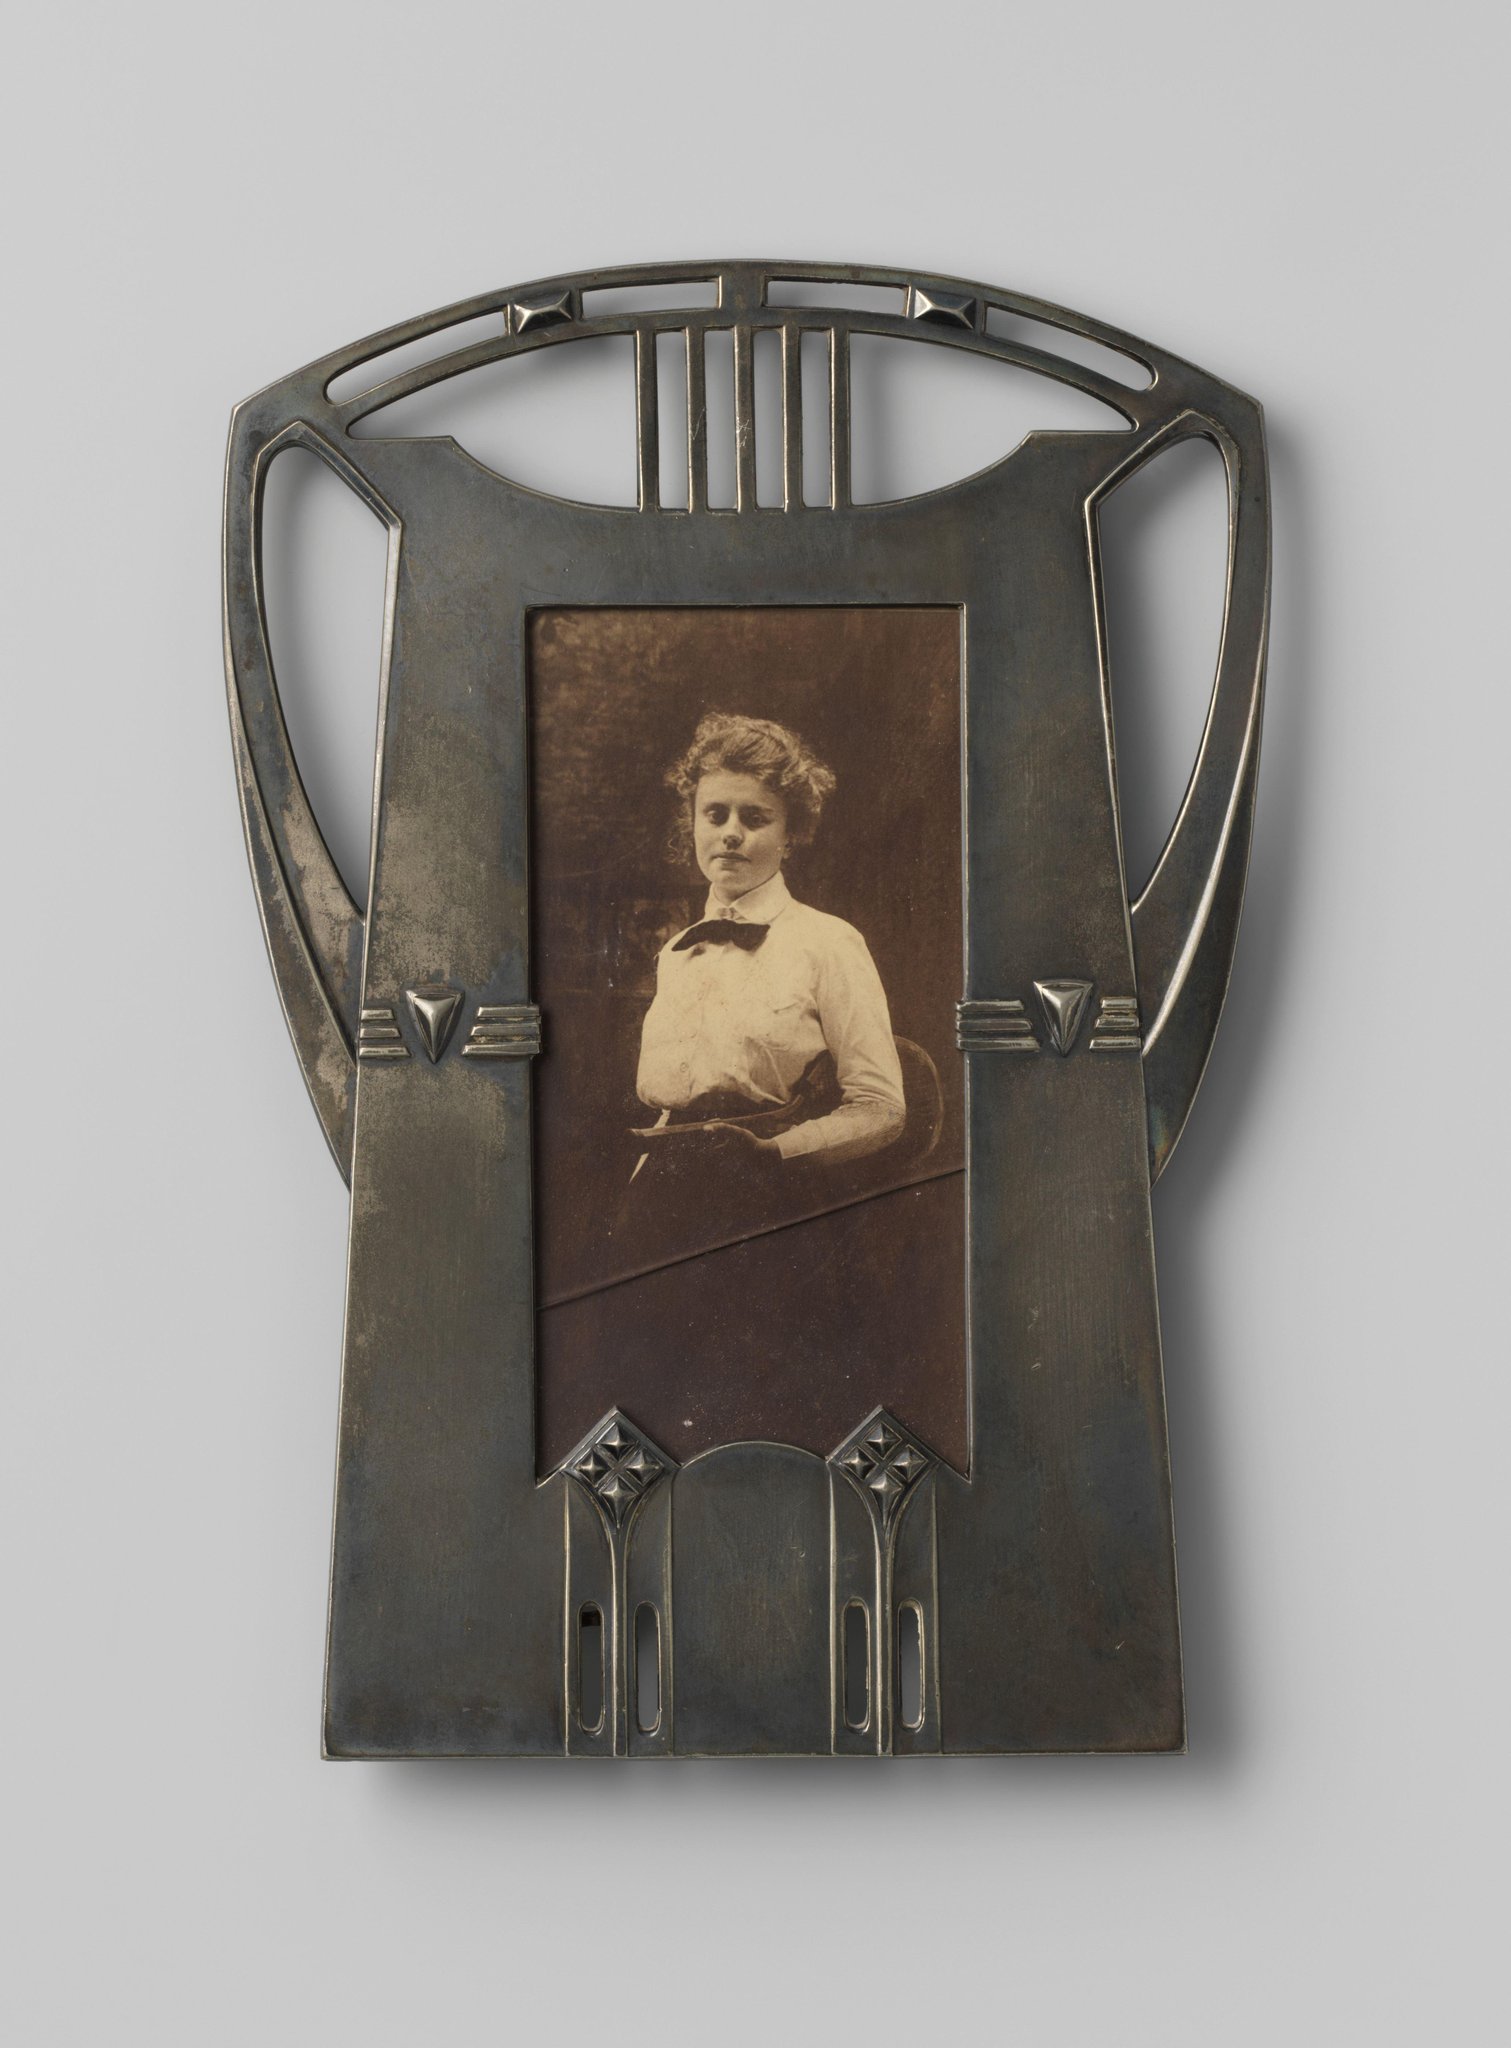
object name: photograph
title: Portret van een onbekende jonge vrouw met een tennisracket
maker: Anonymous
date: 1890-1910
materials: paper, glass, metal, textile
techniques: gelatin silver print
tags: adolescent, young woman, maiden, tennis, lawn-tennis (+ requirements, necessaries ~ sports and games), anonymous historical person portrayed